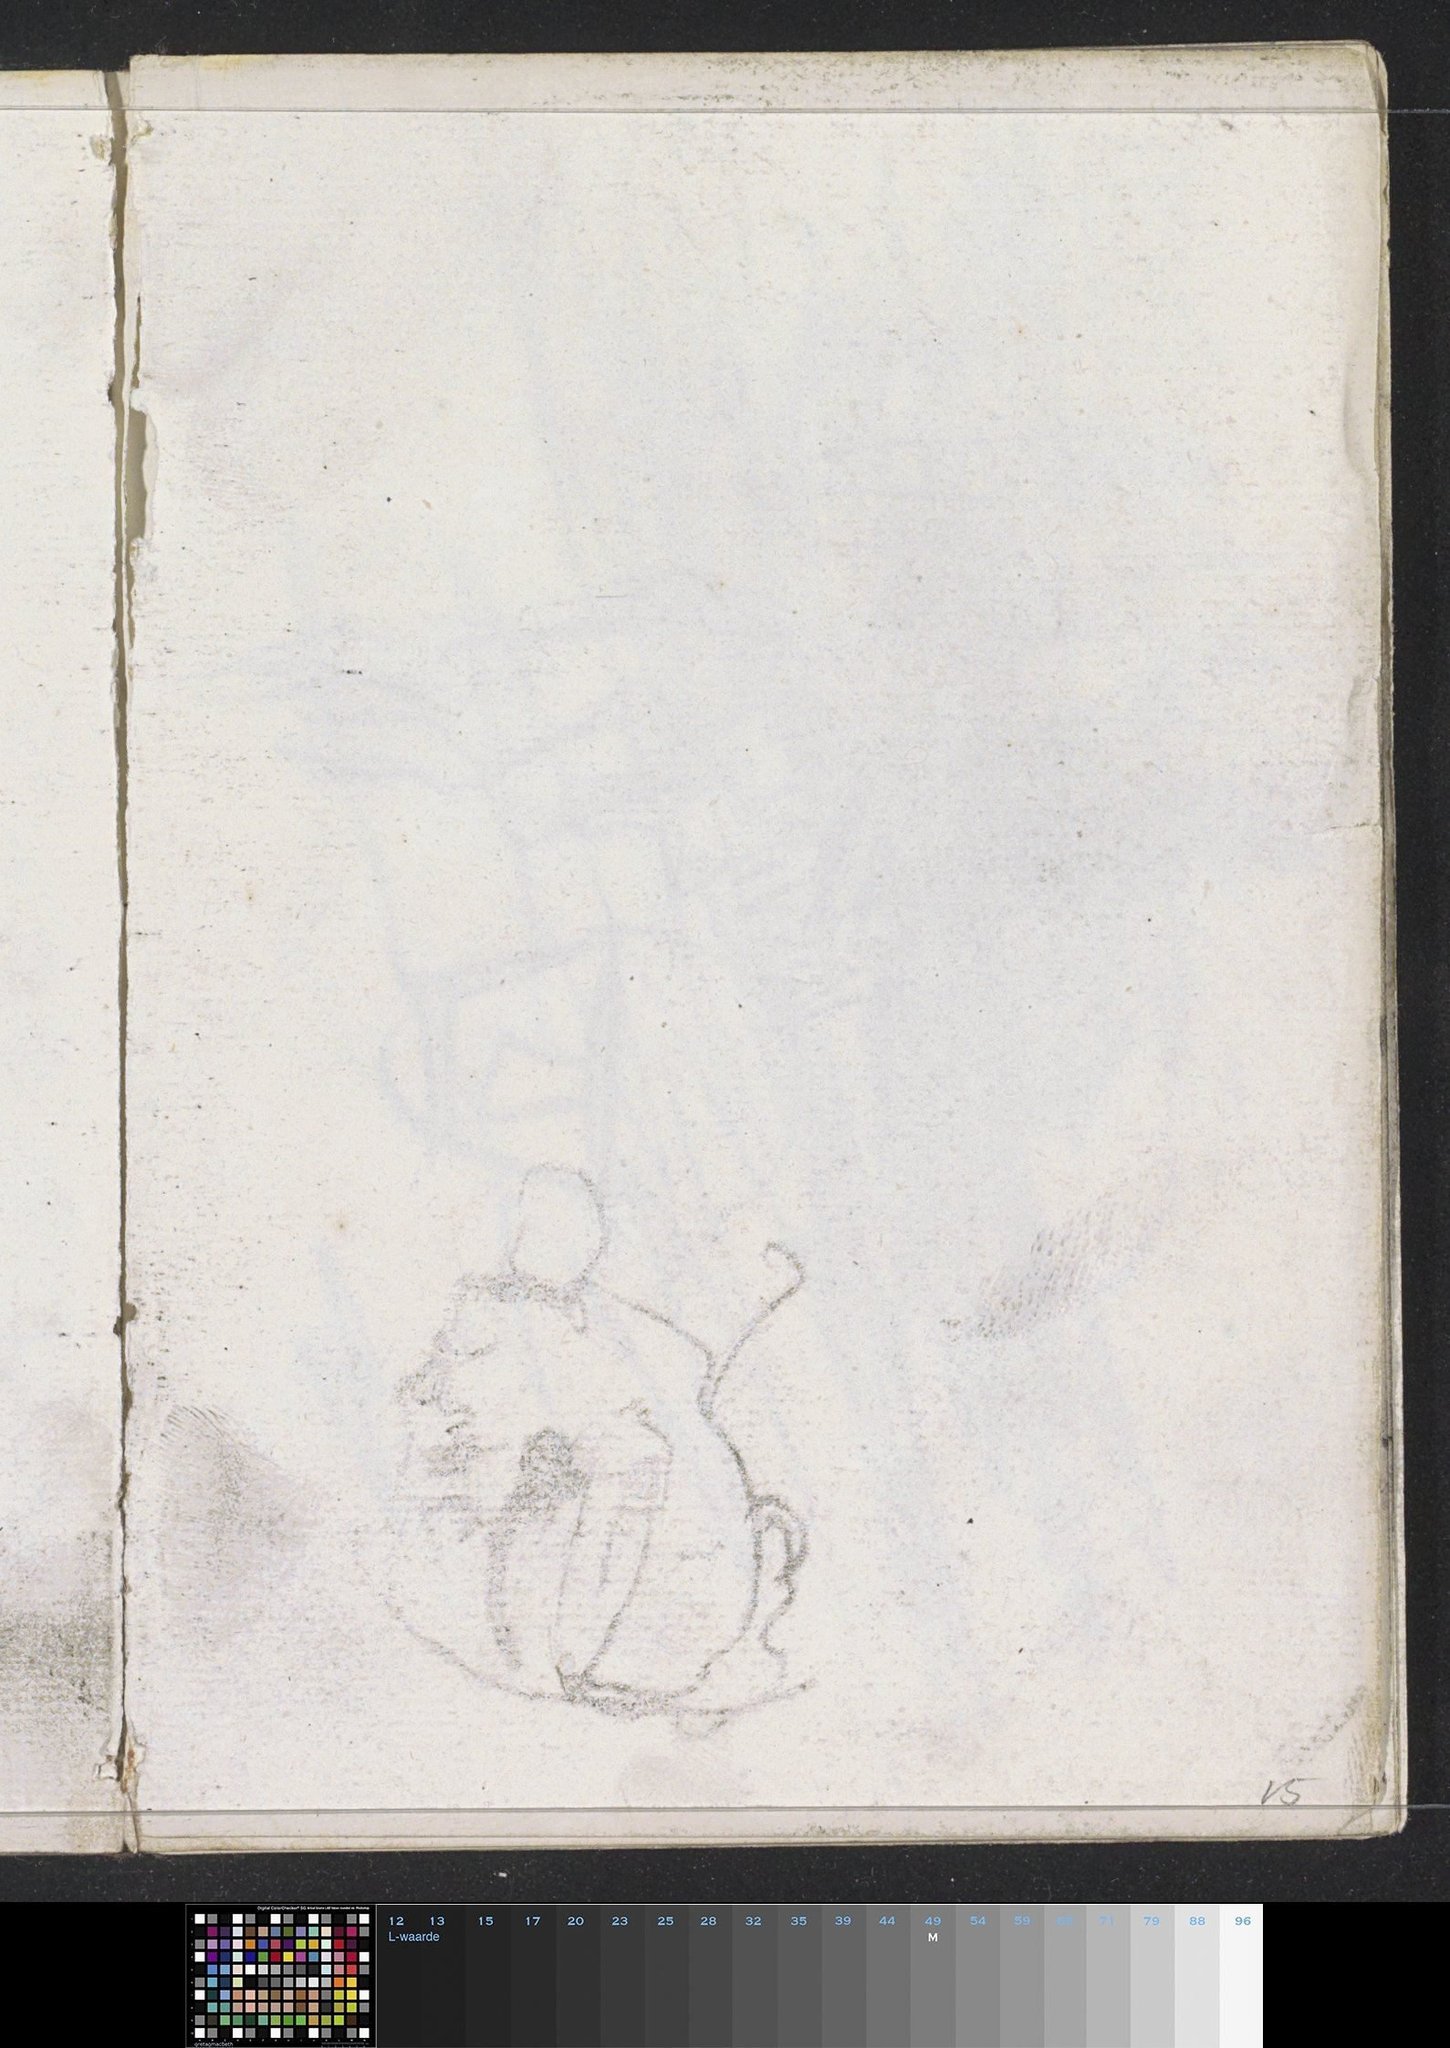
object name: sketchbook leaf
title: Abklatsch van een krijttekening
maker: isaac israels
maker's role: draughtsman, painter, print maker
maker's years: 1865-1934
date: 1886-1934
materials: paper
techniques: printmaking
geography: amsterdam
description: De originele tekening van een meisjeshoofd is niet meer in schetsboek aanwezig. Blad 15 recto uit schetsboek LV met 21 bladen.